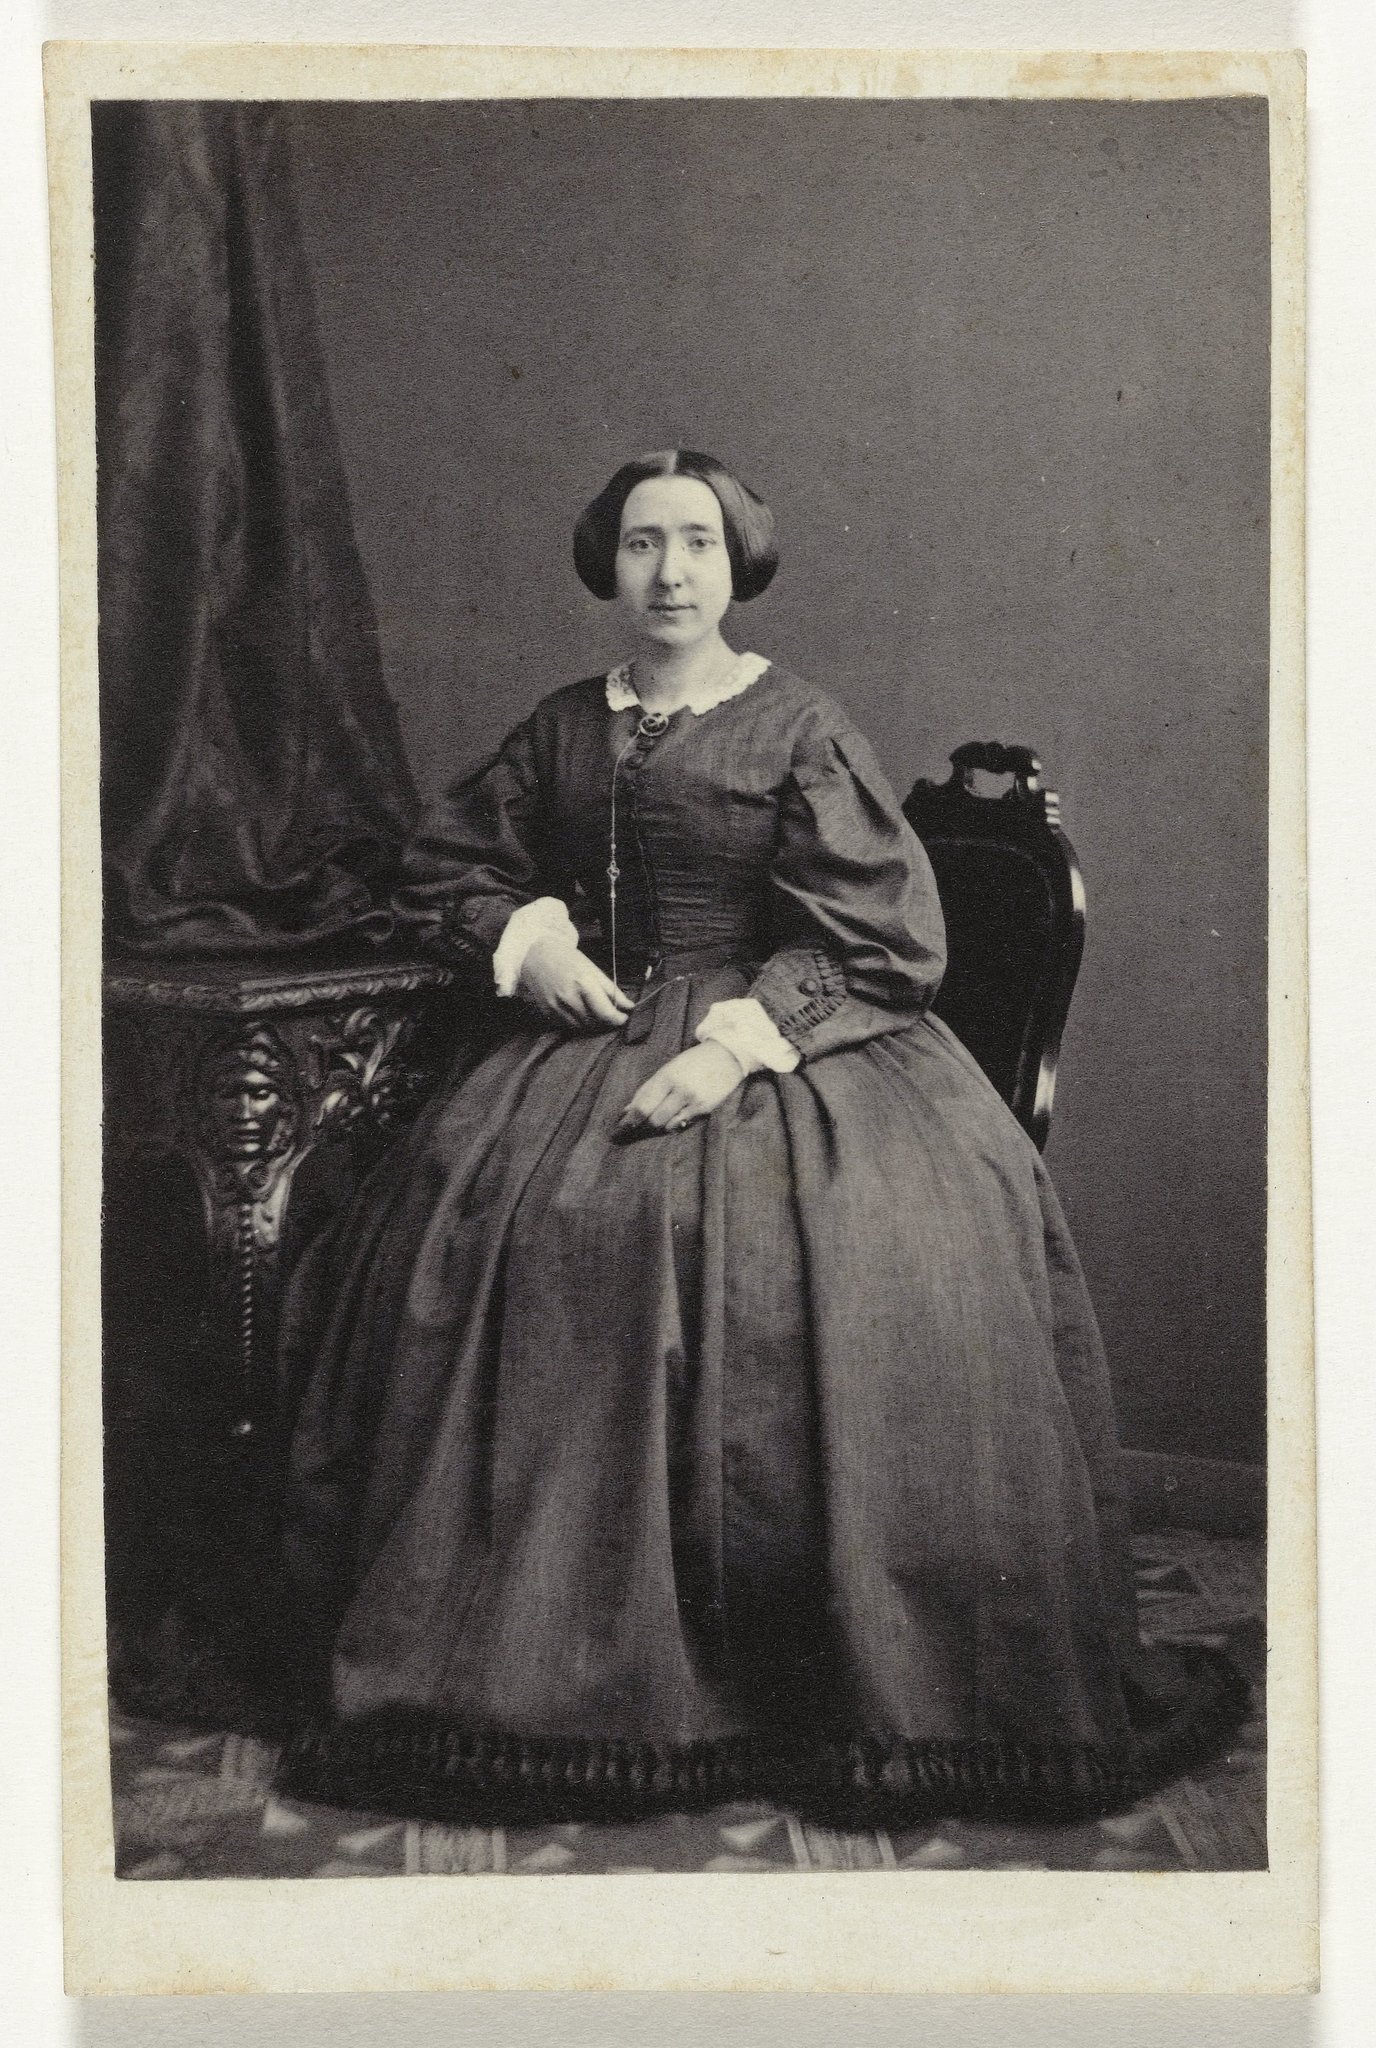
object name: photograph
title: Portret van een vrouw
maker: a. böeseken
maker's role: fotograaf, lithograaf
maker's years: 1834-1919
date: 1865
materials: cardboard, paper, photographic support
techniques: albumen print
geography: rotterdam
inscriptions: address: ‘A. Böeseken/Photograph/Rotterdam/’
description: Vrouw in een donkere japon, zittend aan een tafel.